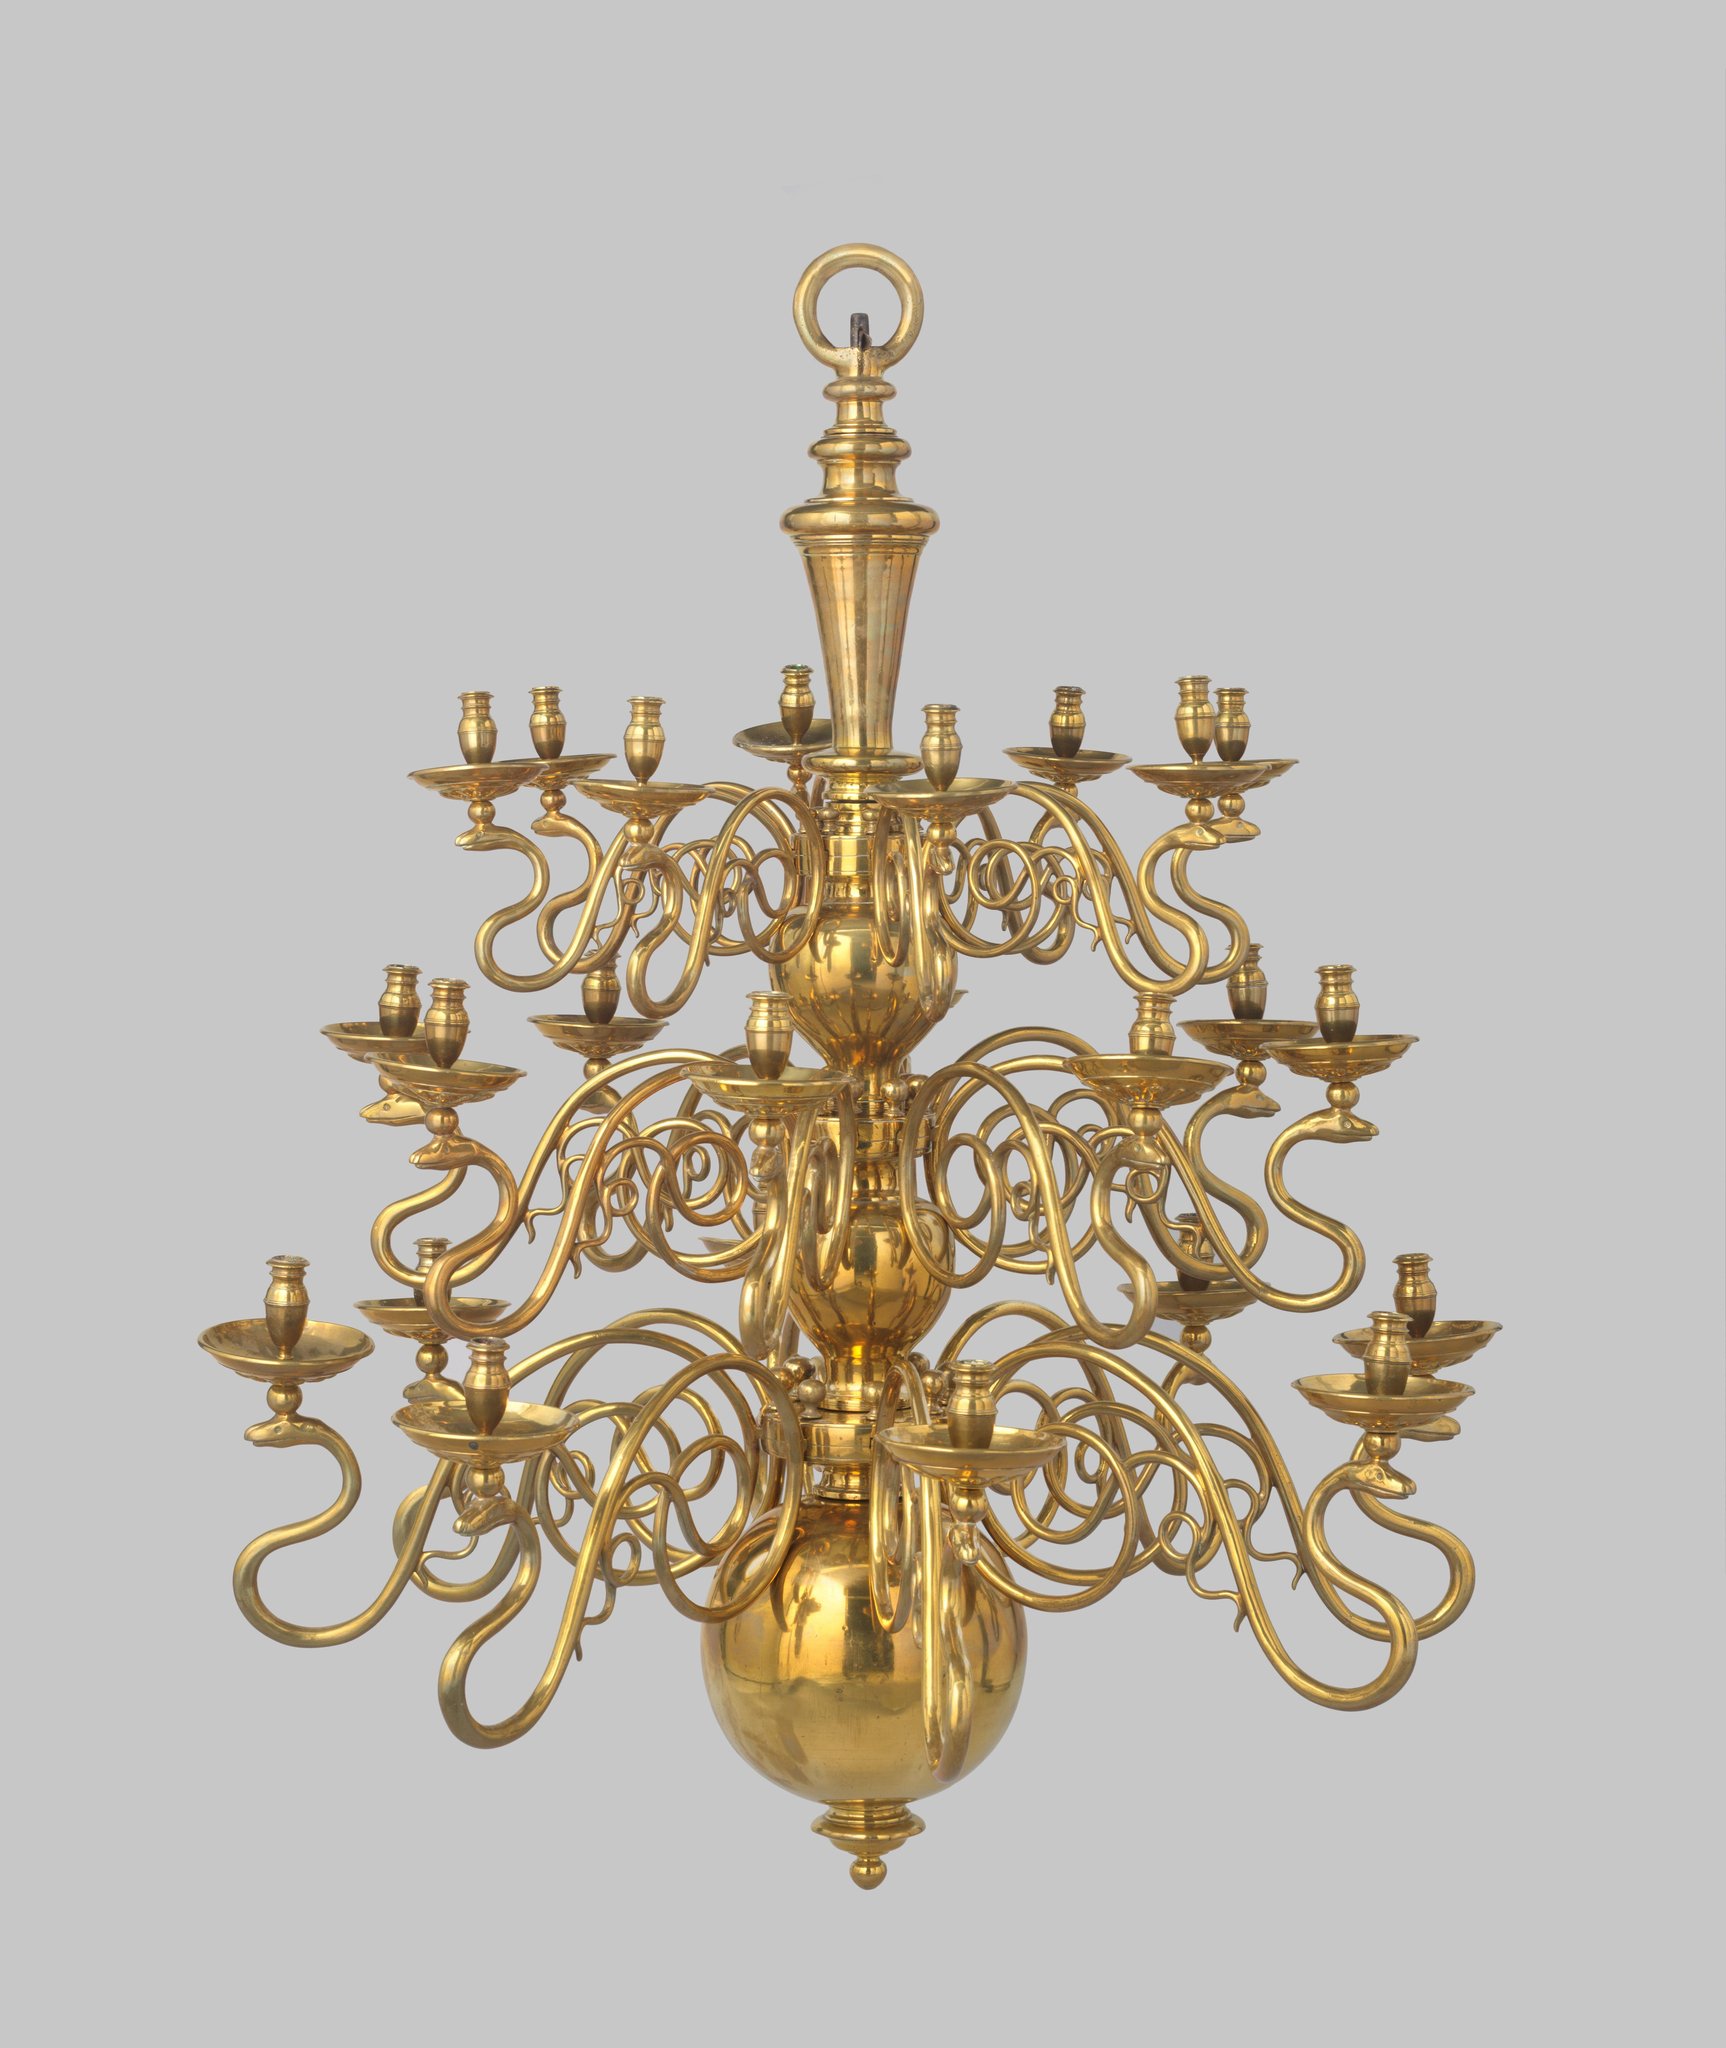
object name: chandelier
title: Arm van een kaarsenkroon in drie hoogten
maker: Anonymous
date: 1625-1650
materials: brass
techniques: screwed, turning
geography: northern netherlands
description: De arm is aan de stamzijde voorzien van een nok, waarin een gat is aangebracht om ze met een pin in de standringen te kunnen vastzetten. De S-vormige arm heeft de gedaante van een slang met een naar de stamzijde gekronkelde staart en naar buiten toe een opgeheven kop met daarop een ronde knop, waarin het van een schroefdraad voorziene gat is aangebracht ter bevestiging van de kaarsenhouders met de vetvangers. De arm is met behulp van hetzelfde model gegoten als de overige armen van de krans. De ronde kaarsenhouder is vaasvormig met een geprofileerde rib. Bovenaan heeft zij twee holronde profileringen, en een uitkragende rand en onderaan een uit twee holronde profileringen bestaande voet. De voet loopt uit in een zich verjongend schroefeind met een centergat. De bolle vetvanger is aan de bovenkant glad en heeft aan de onderkant visblaasachtige godrons en een rib. De vetvanger is met behulp van hetzelfde model gegoten als de overige vetvangers van de krans. De pinnen zijn met bolle knoppen versierd. Dit is de vierde arm van de onderste standring, genummerd op de nok met het cijfer IV.